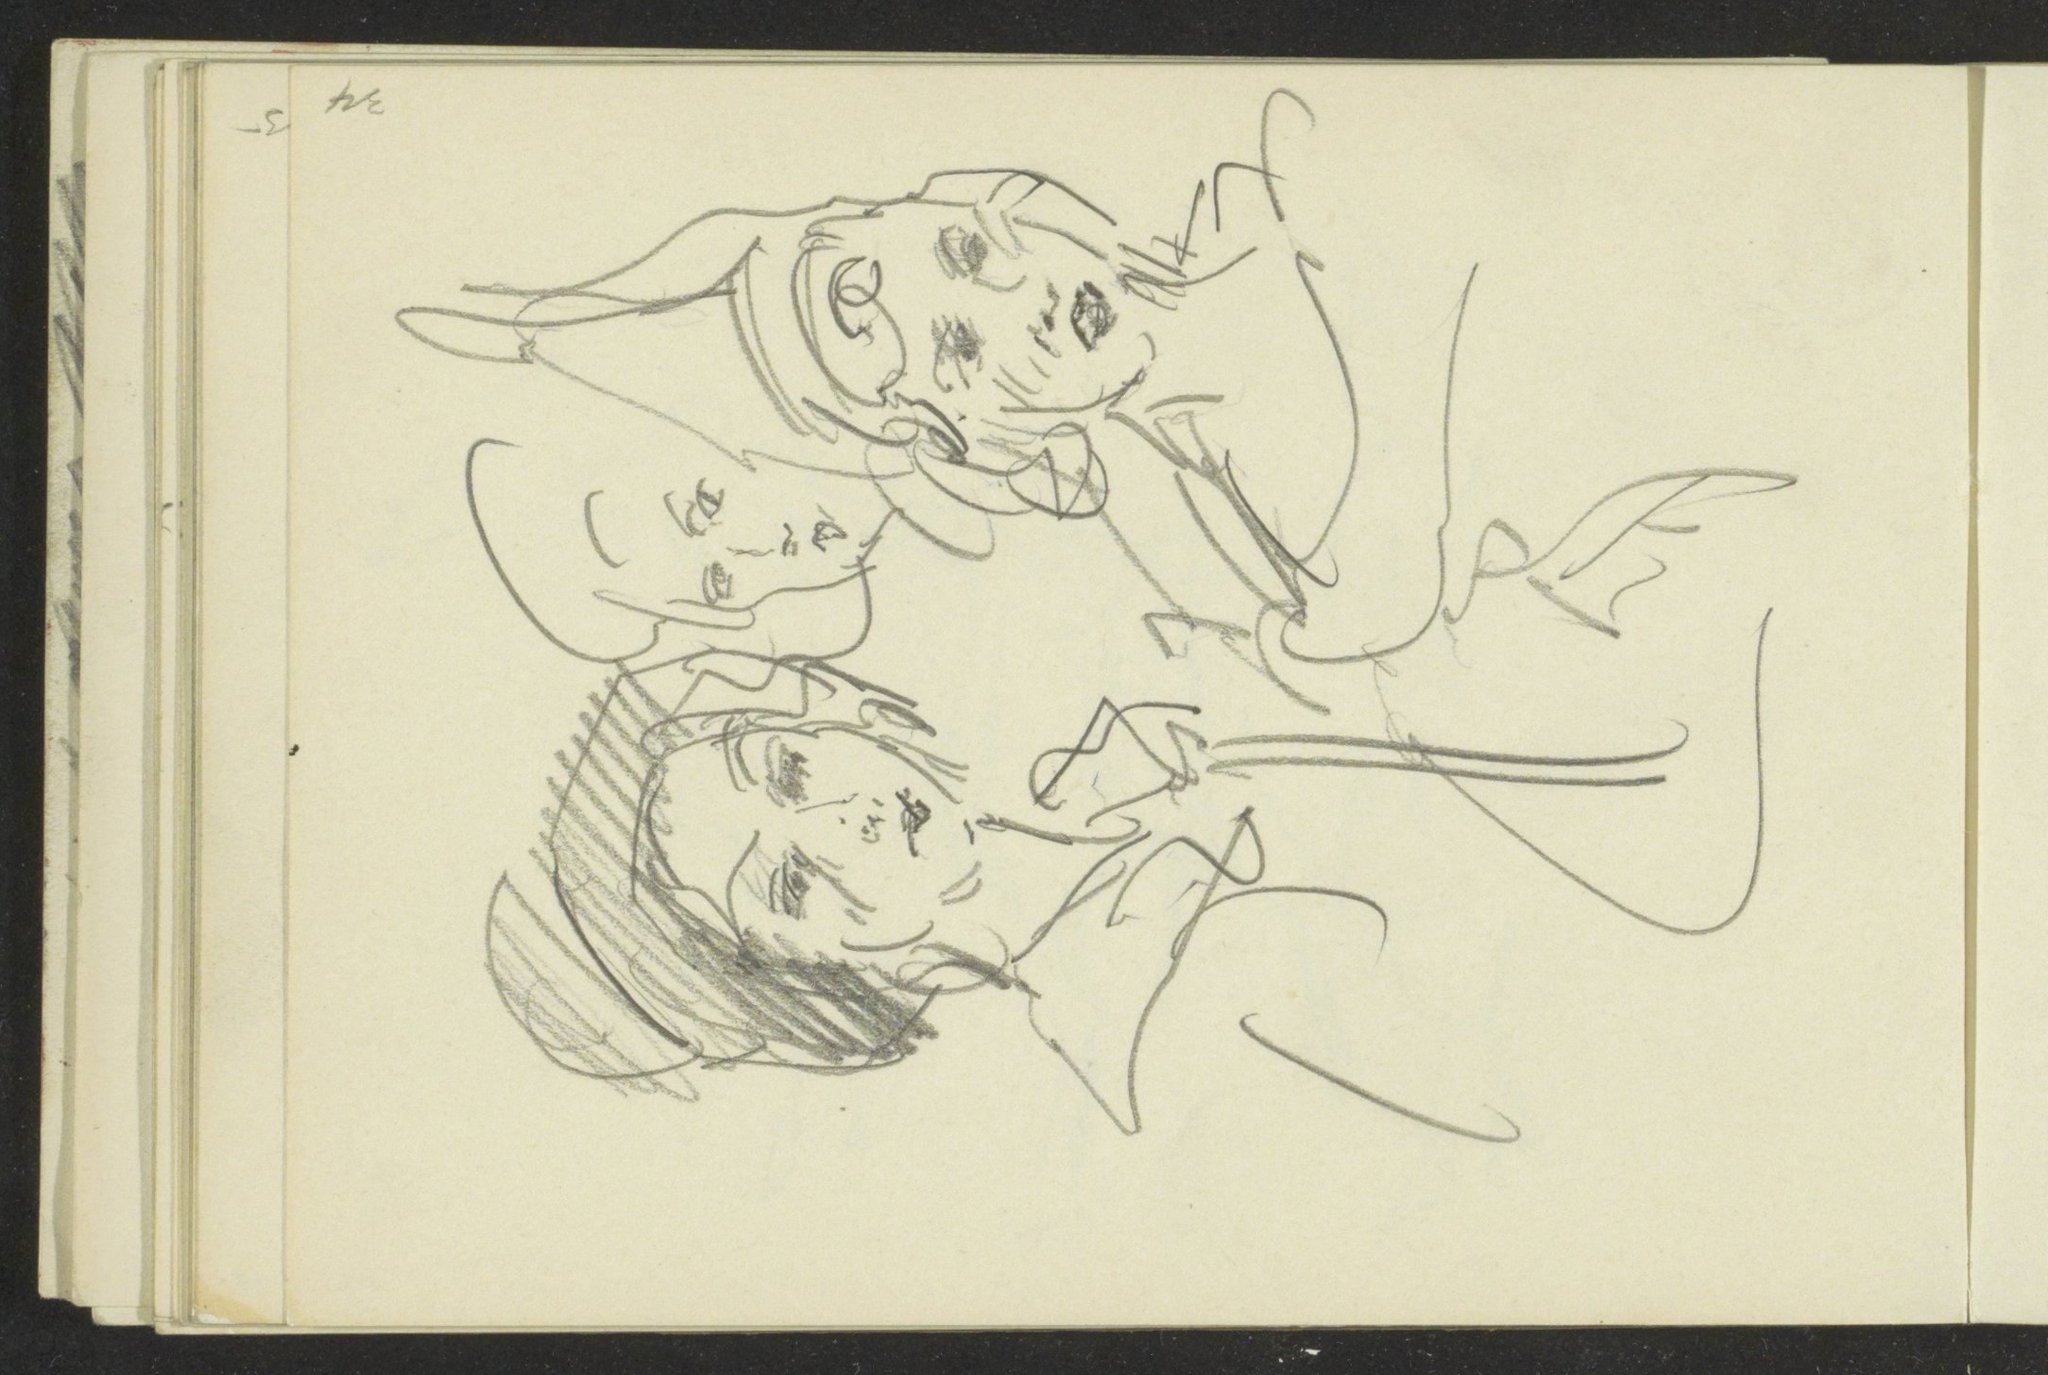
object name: sketchbook leaf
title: Drie vrouwen in kostuums, mogelijk variétédanseressen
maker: isaac israels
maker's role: draughtsman, painter, print maker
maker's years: 1865-1934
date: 1875-1934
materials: paper, pencil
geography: the hague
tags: adult woman, stage costume - cc - female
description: Blad 17 verso uit schetsboek LXV met 27 bladen.